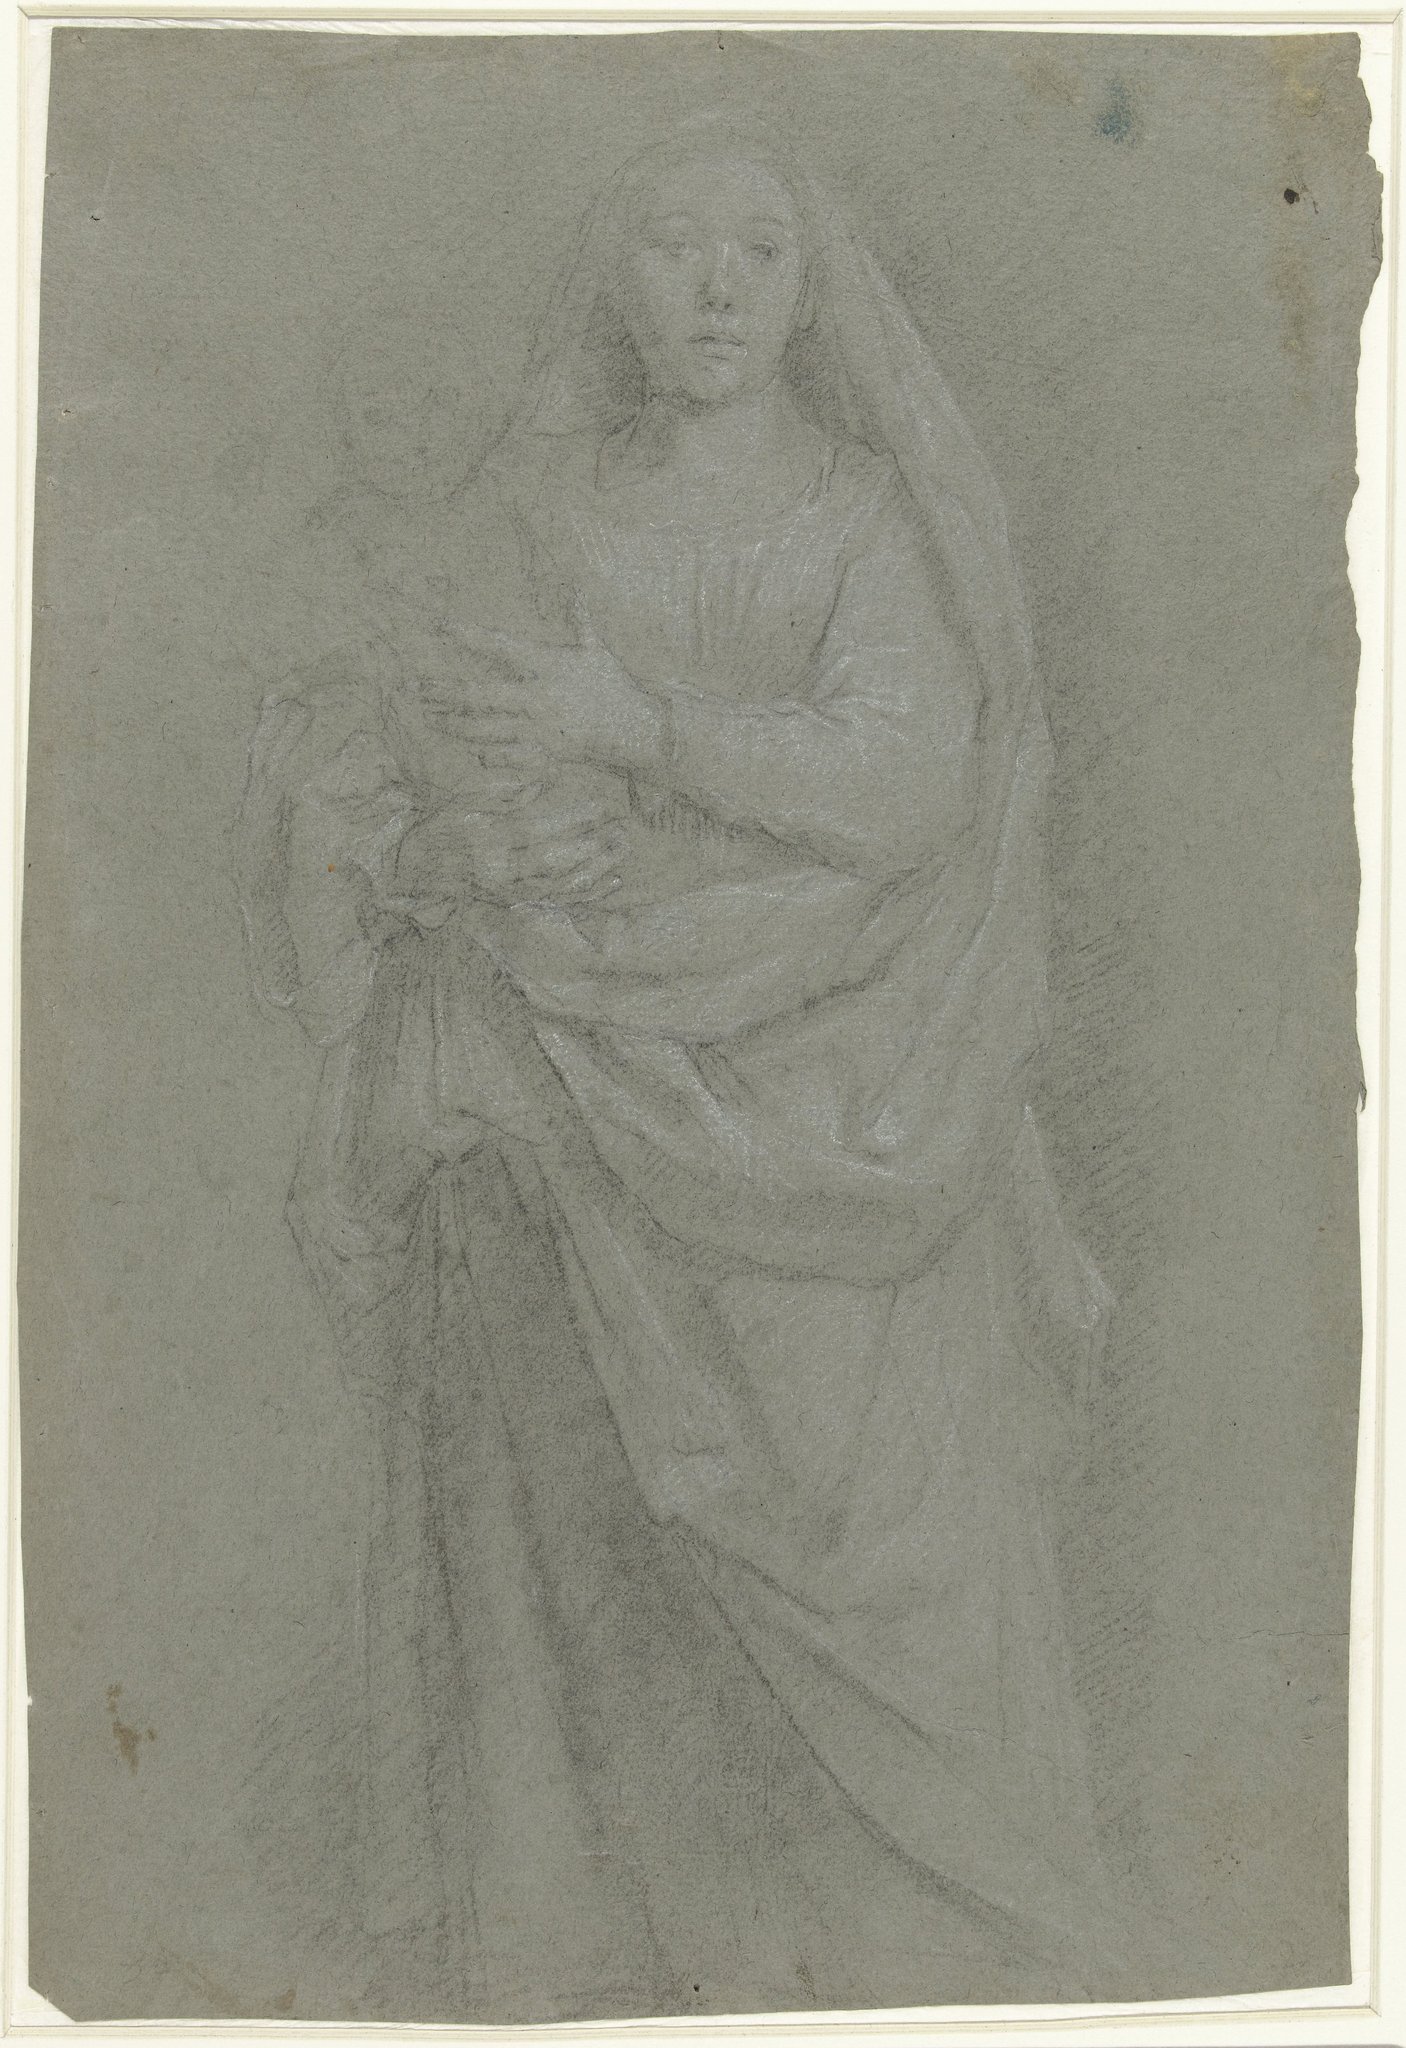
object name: drawing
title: Schetsbladen met figuurstudies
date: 1600-1699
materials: chalk, paper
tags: mother and baby or young child, standing figure - aa - female human figure, mary standing (or half-length), the christ-child sitting on her arm (christ-child to mary's left) - ff - the christ-child to mary's right